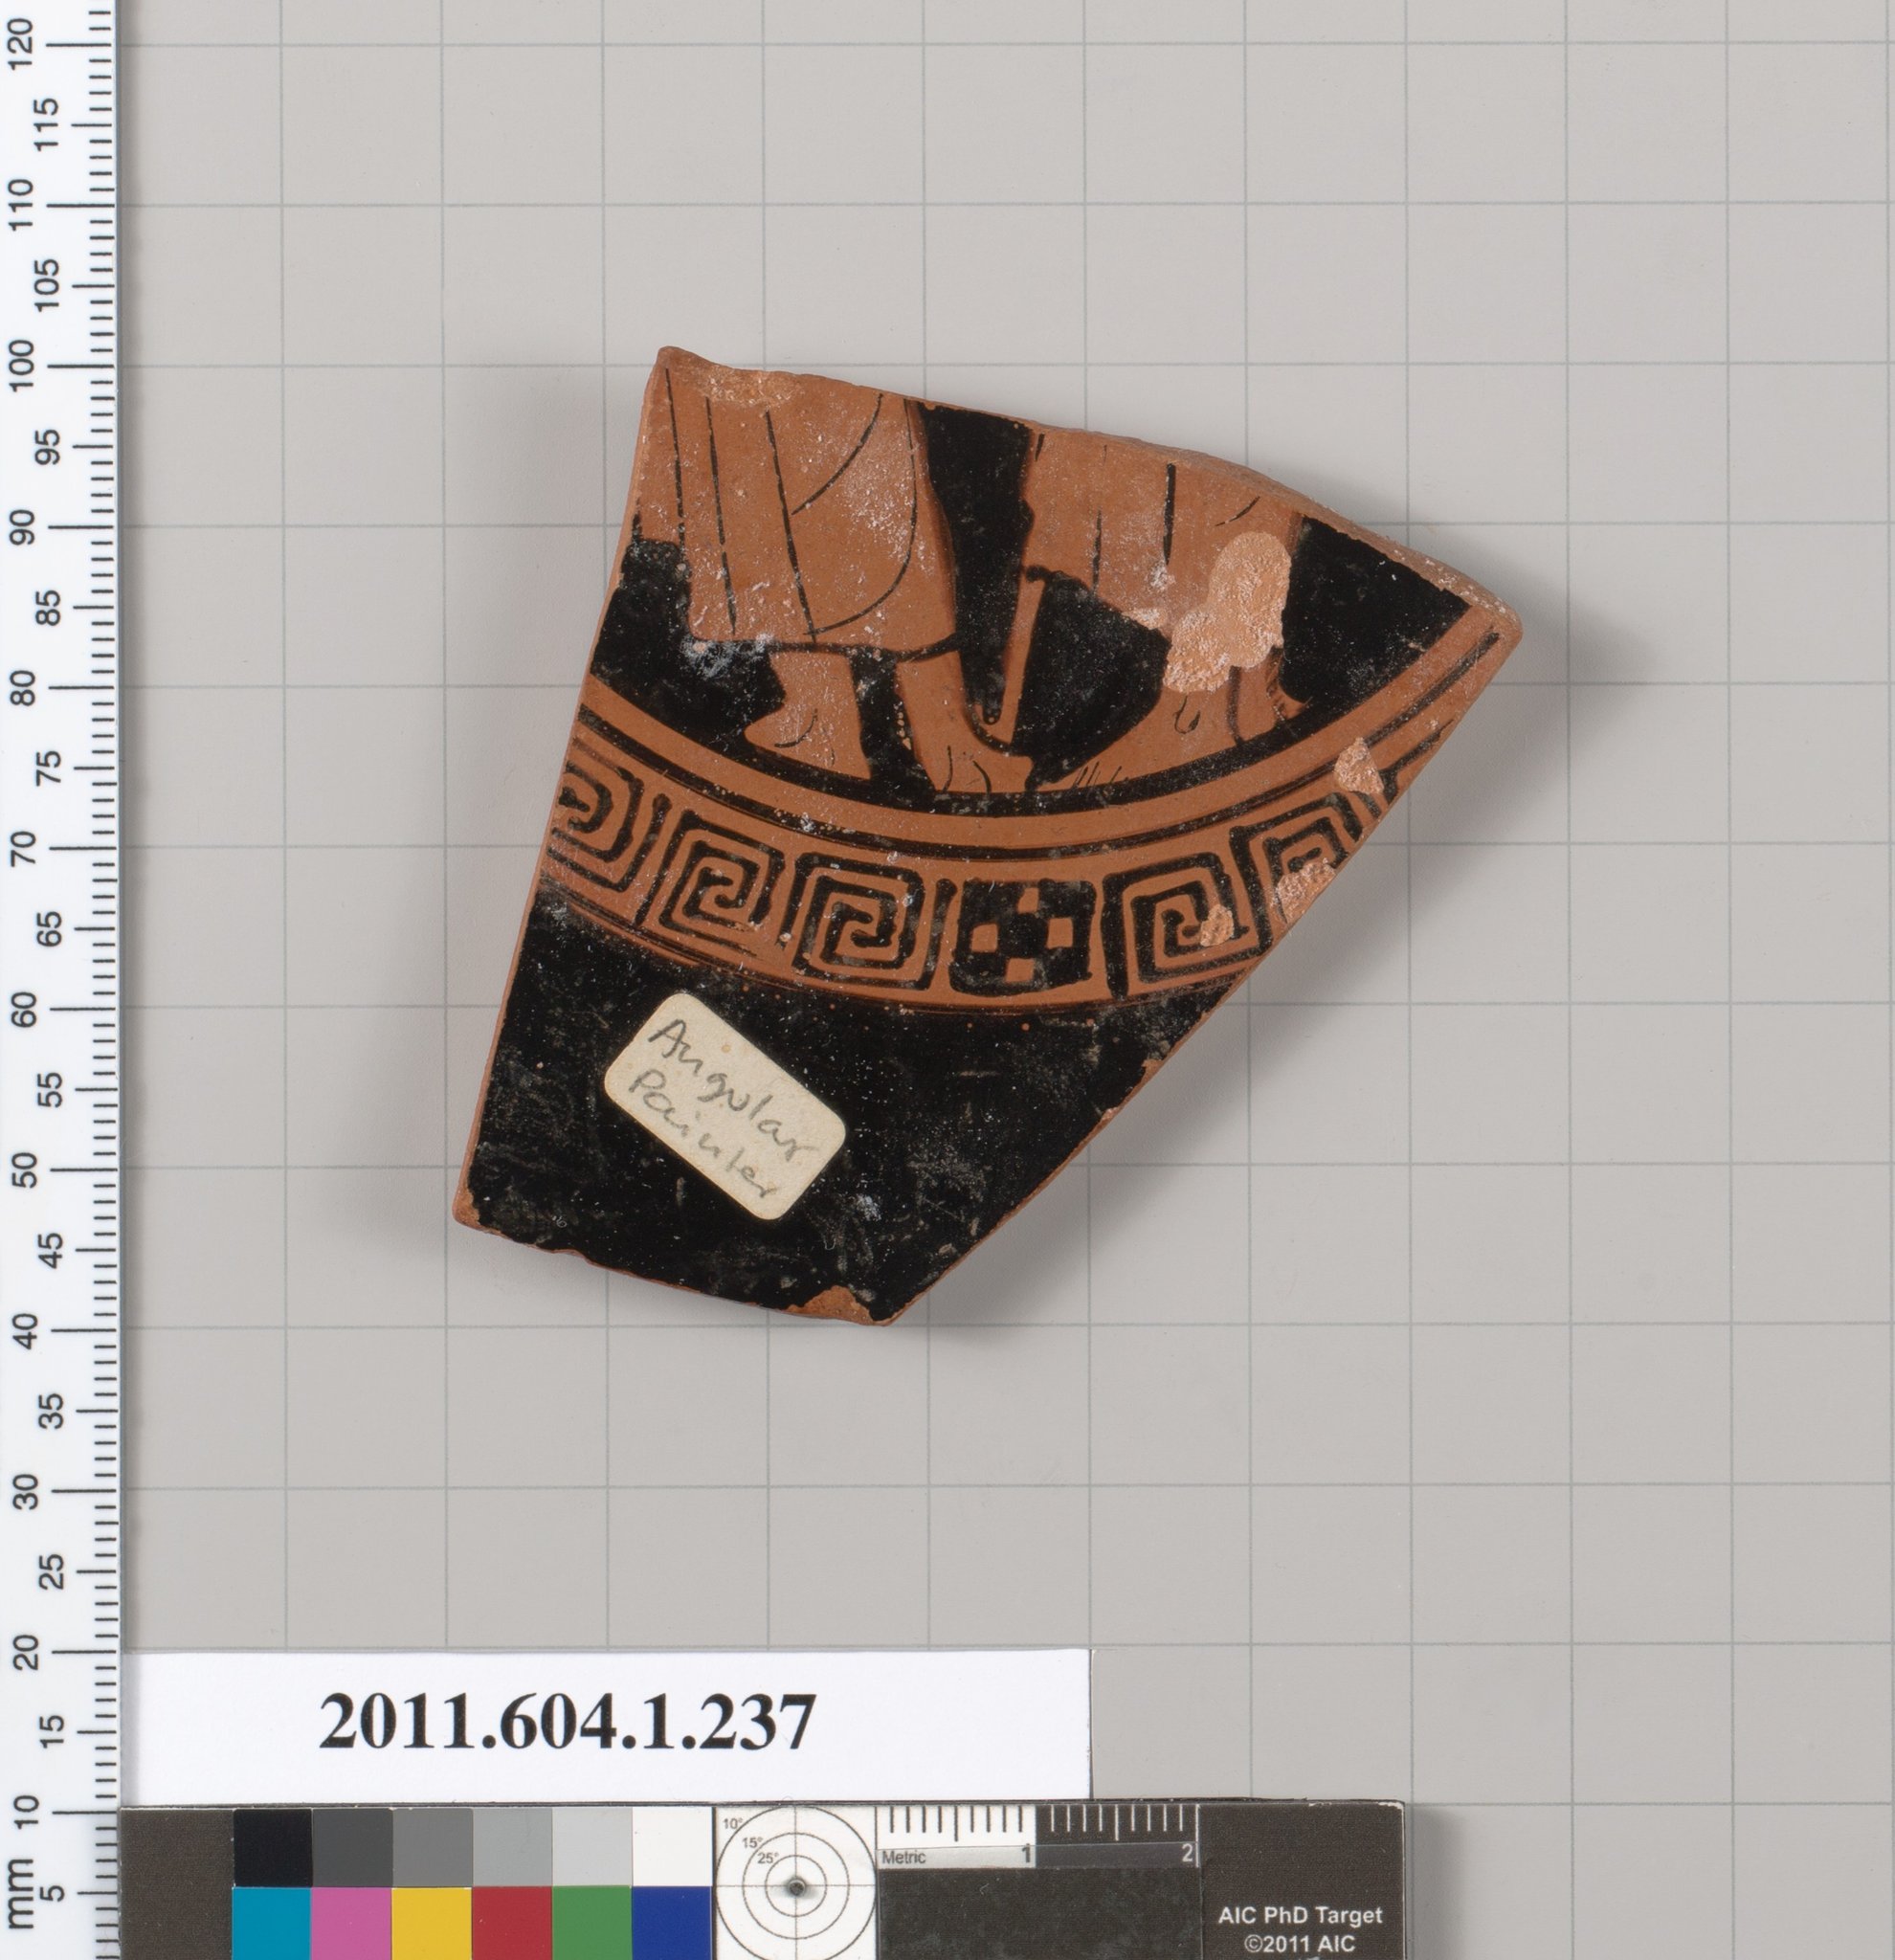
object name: kylix fragment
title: Terracotta fragment of a kylix (drinking cup)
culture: greek, attic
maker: angular painter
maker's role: artist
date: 475-451 BCE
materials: terracotta